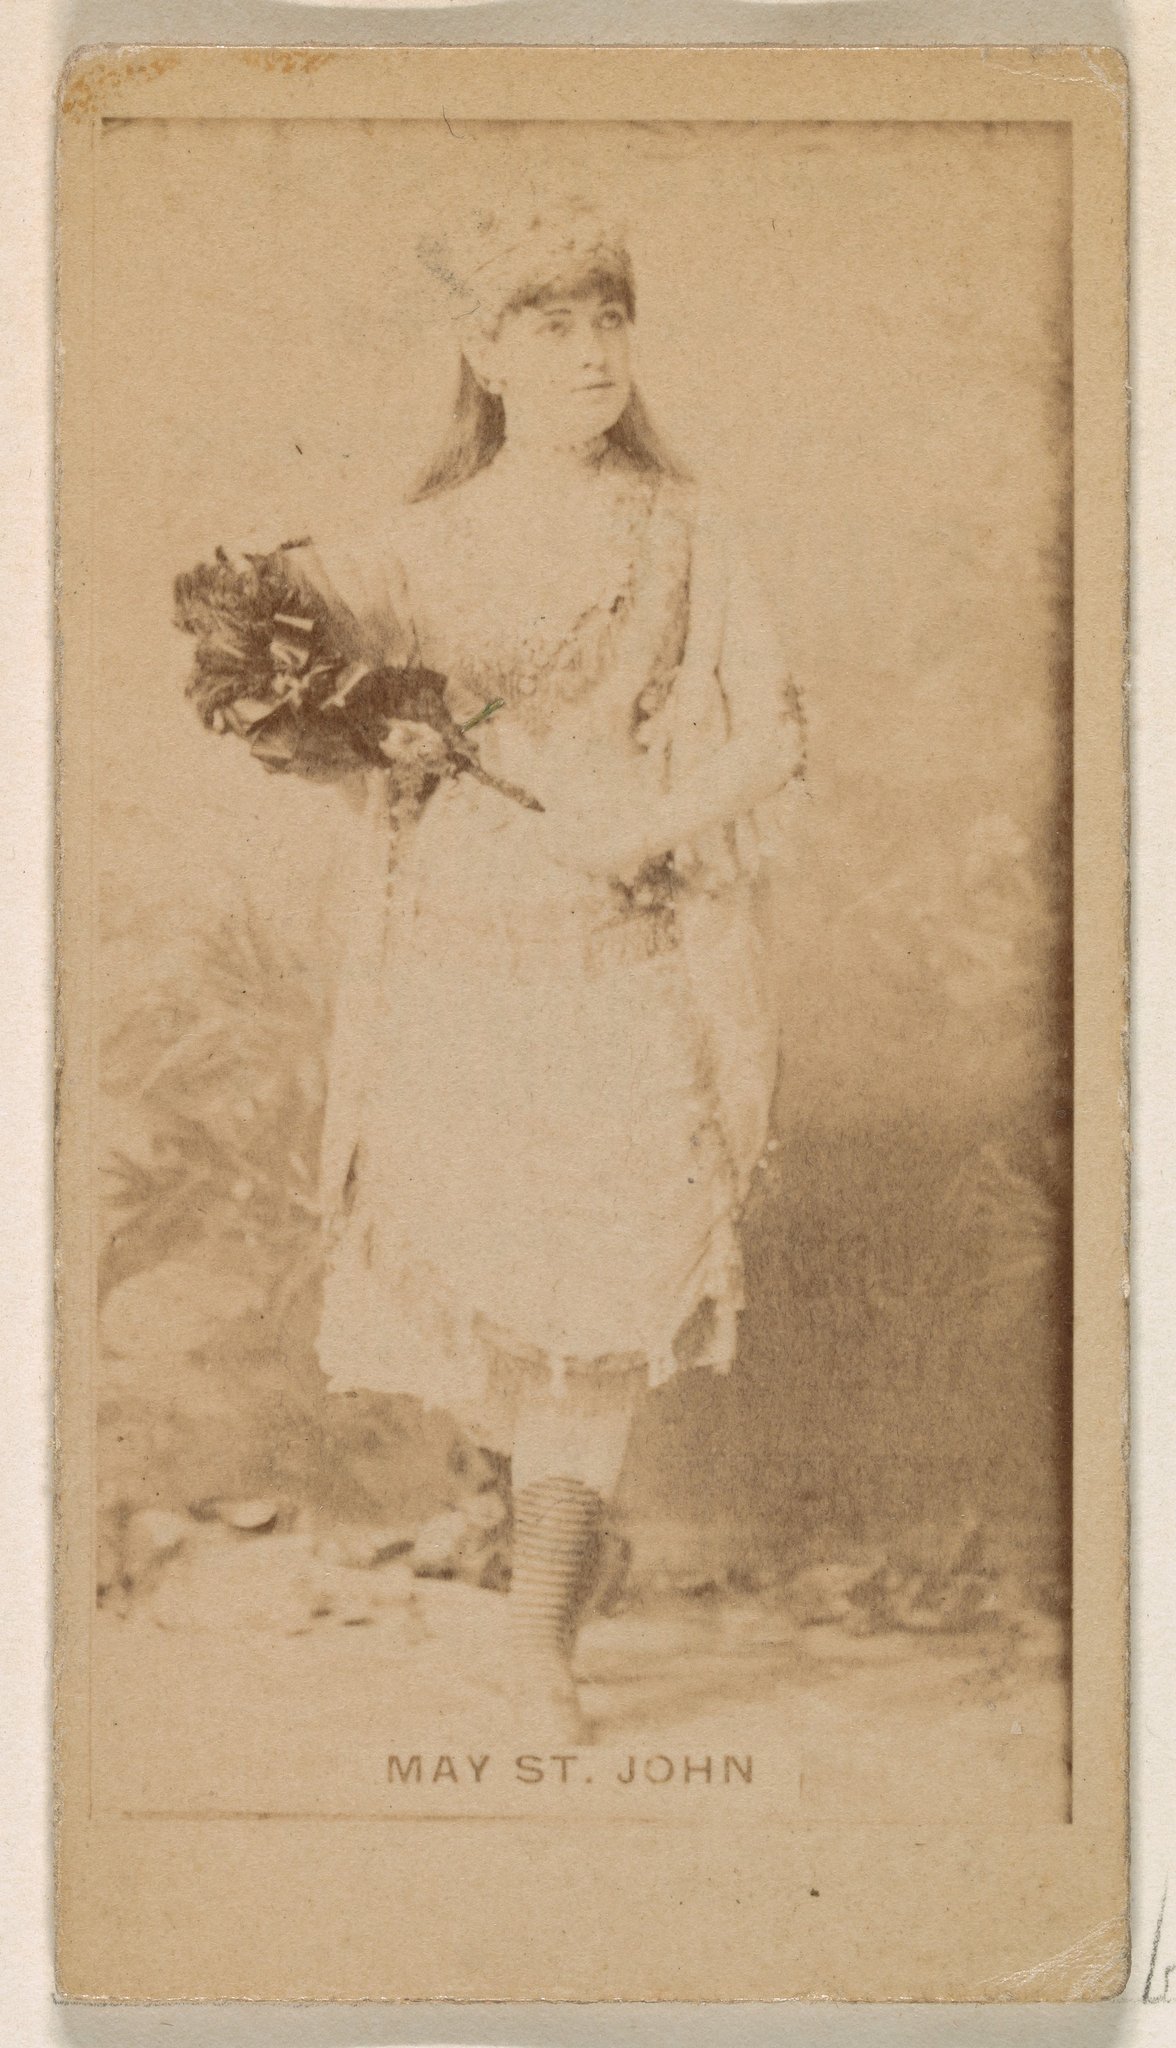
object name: photograph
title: May St. John, from the Actresses series (N245) issued by Kinney Brothers to promote Sweet Caporal Cigarettes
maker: kinney brothers tobacco company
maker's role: publisher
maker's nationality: american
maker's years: 1869-2011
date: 1890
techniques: albumen silver print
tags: portraits,women,actresses